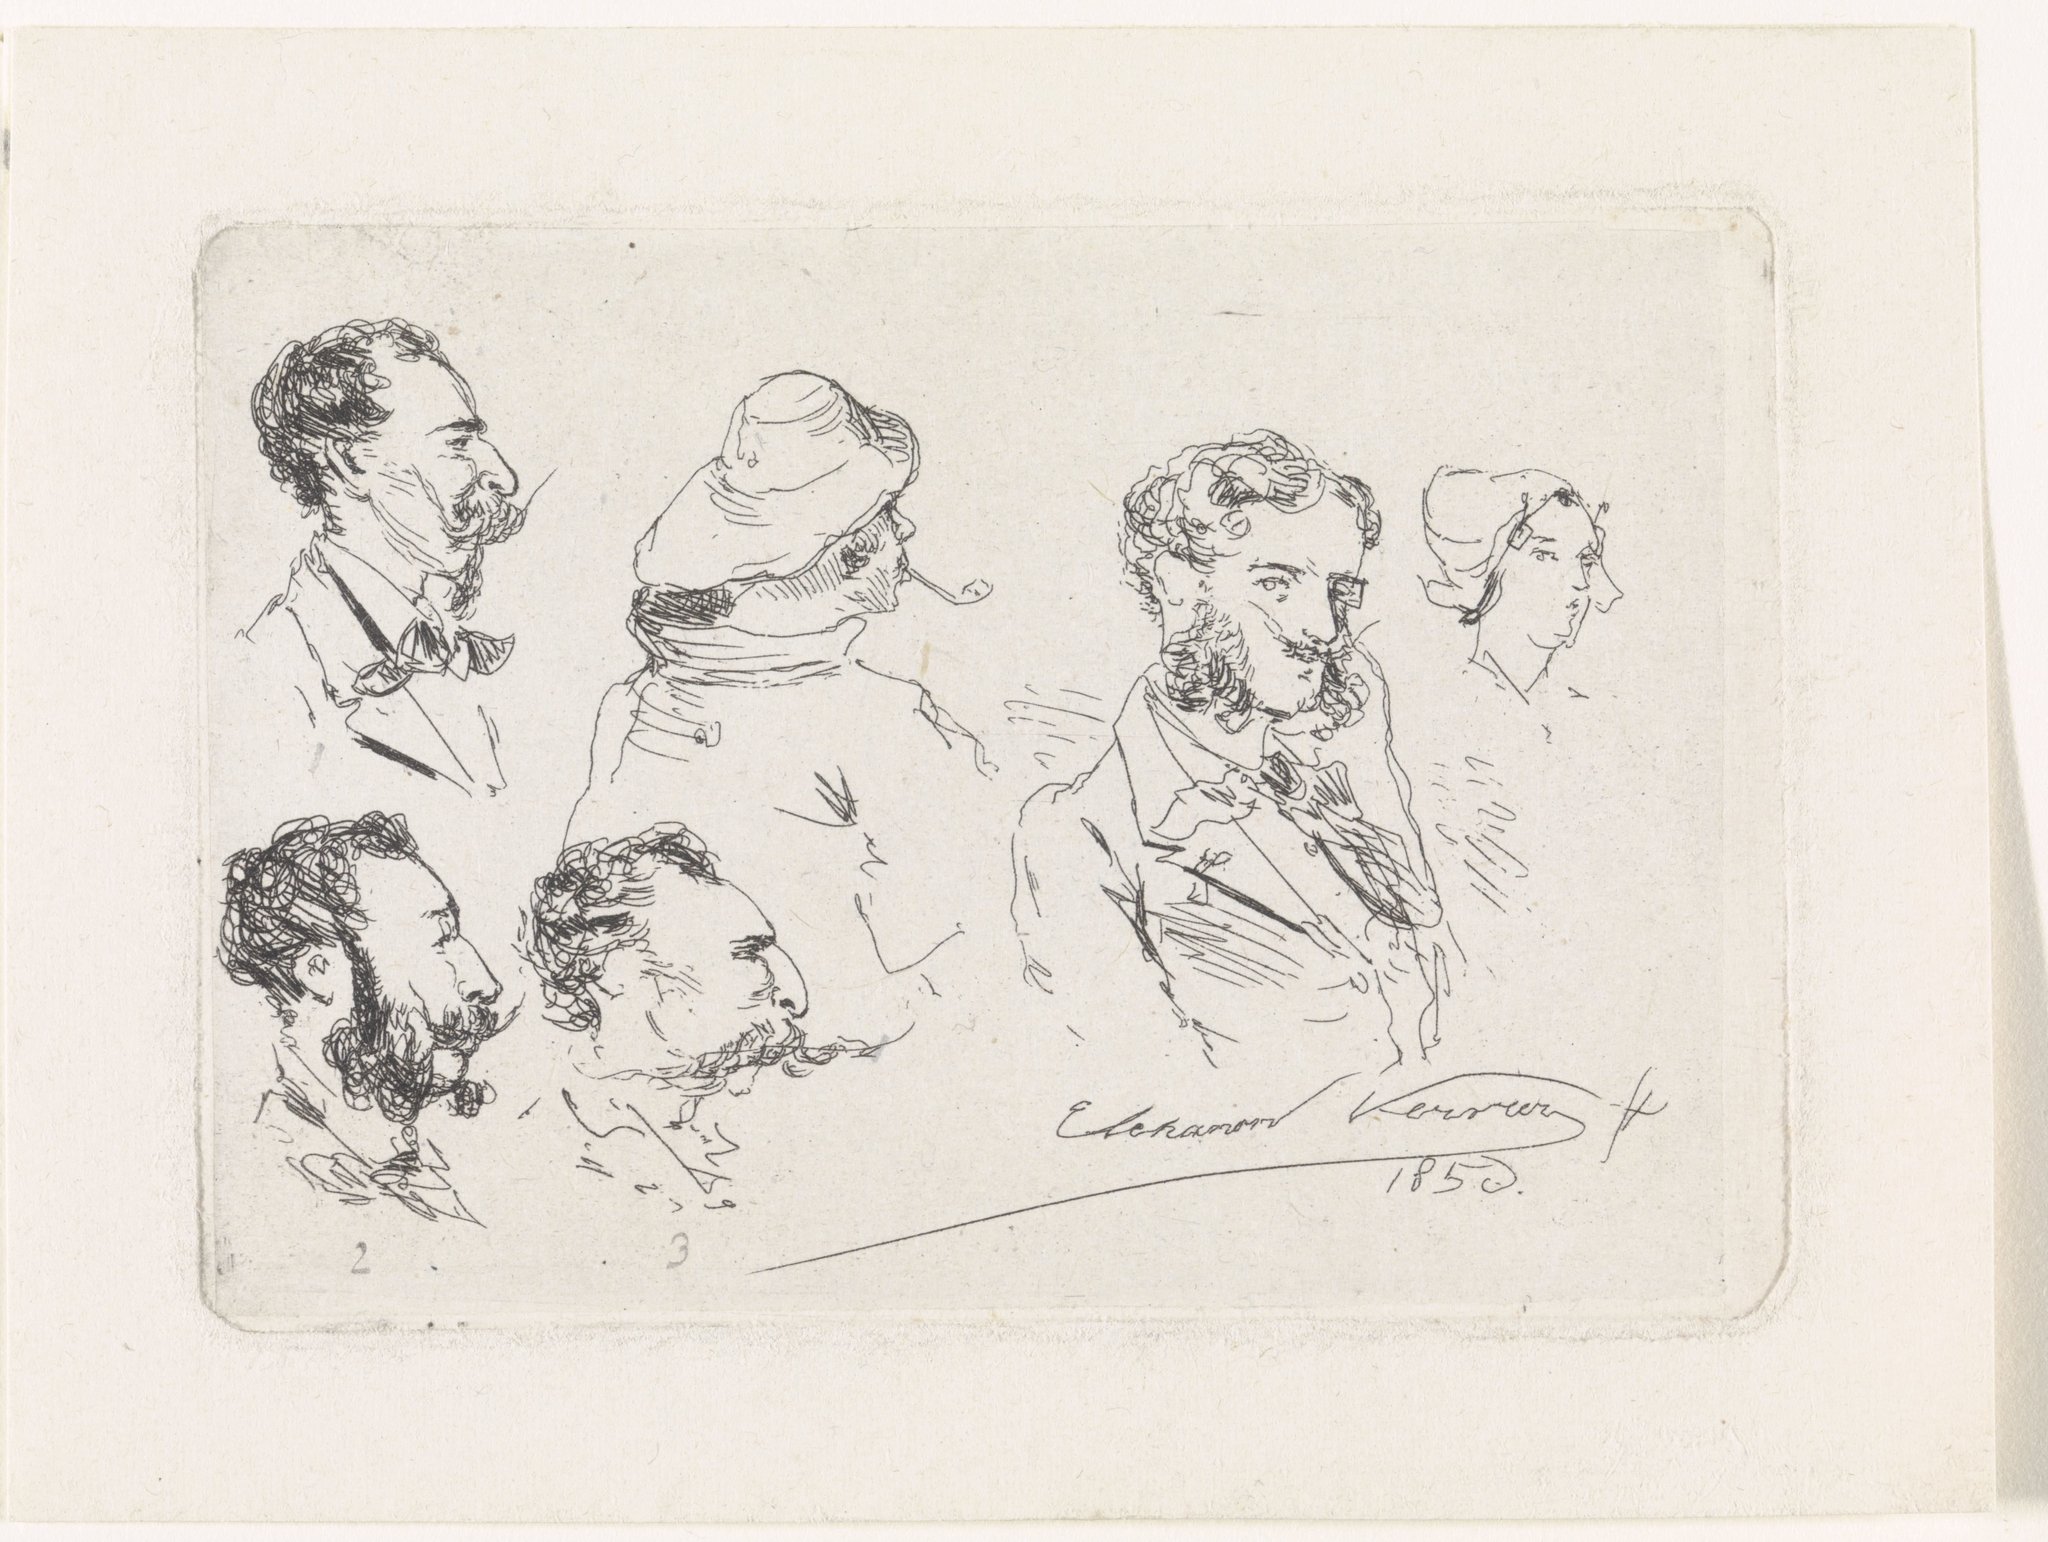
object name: print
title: Zes portretten, waaronder de portretten van de broers Verveer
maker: elchanon verveer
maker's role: draughtsman, print maker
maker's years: 1826-1900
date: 1856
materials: paper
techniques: etching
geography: the hague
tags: salomon leonardus verveer, print maker, elchanon verveer, painter, maurits verveer, moustache, farmers - aa - female farmer, farmer's wife, fisherman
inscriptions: collector's mark: Lugt 2228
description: Studieblad met vier koppen van heren met snorren, een kop van een visser en een kop van een boerin. Linksboven het portret van Elchanon Verveer, linksonder het portret van Maurits Verveer en rechts daarnaast het portret van Samuel Verveer.